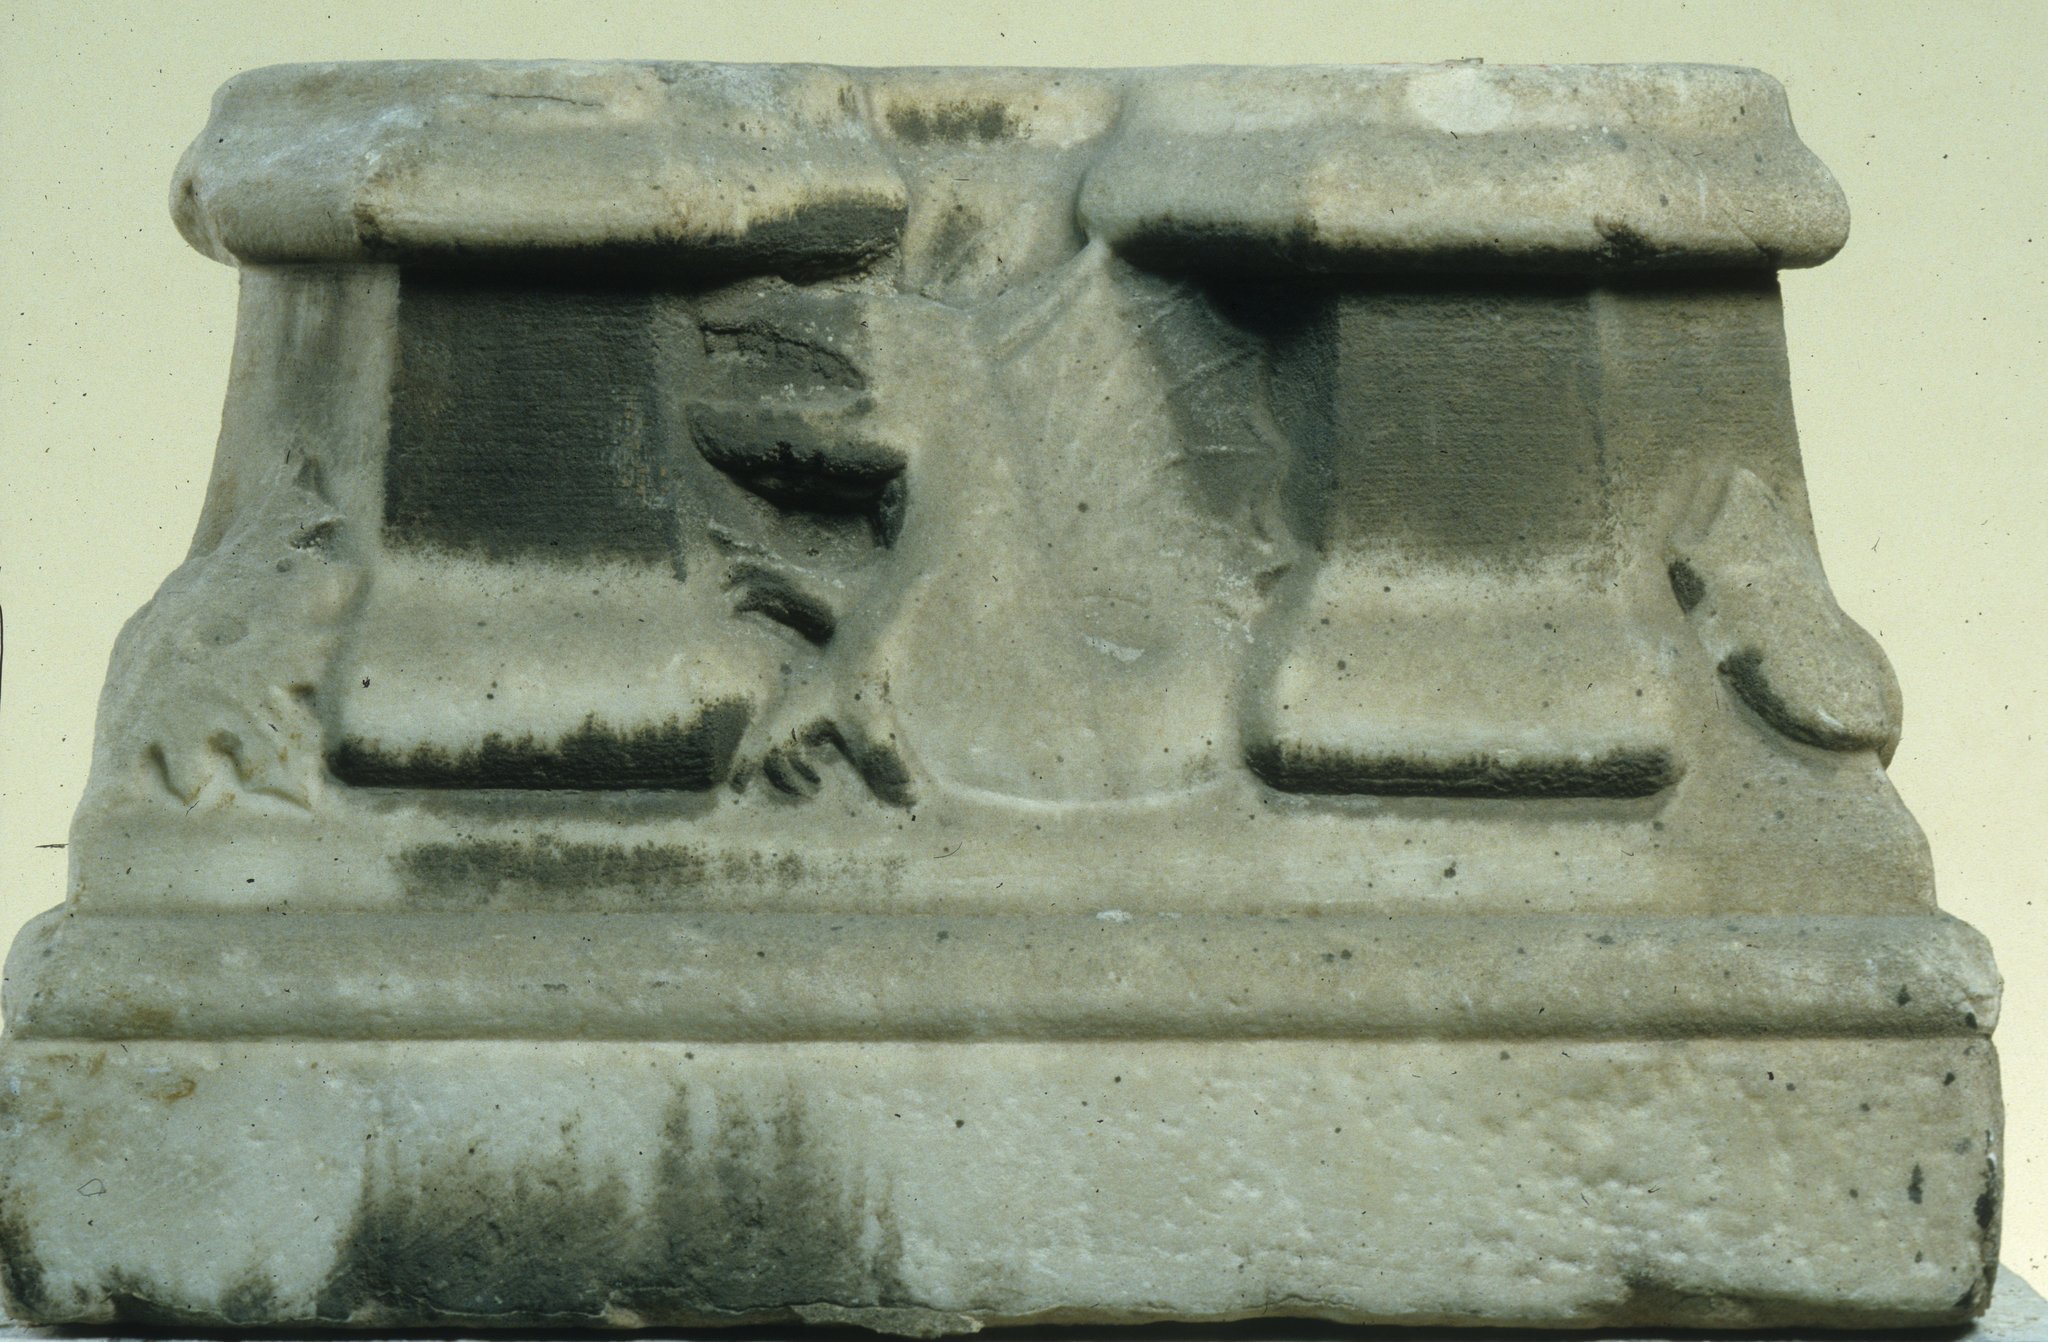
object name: base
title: Double Column Base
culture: french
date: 1467-1500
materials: marble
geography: france